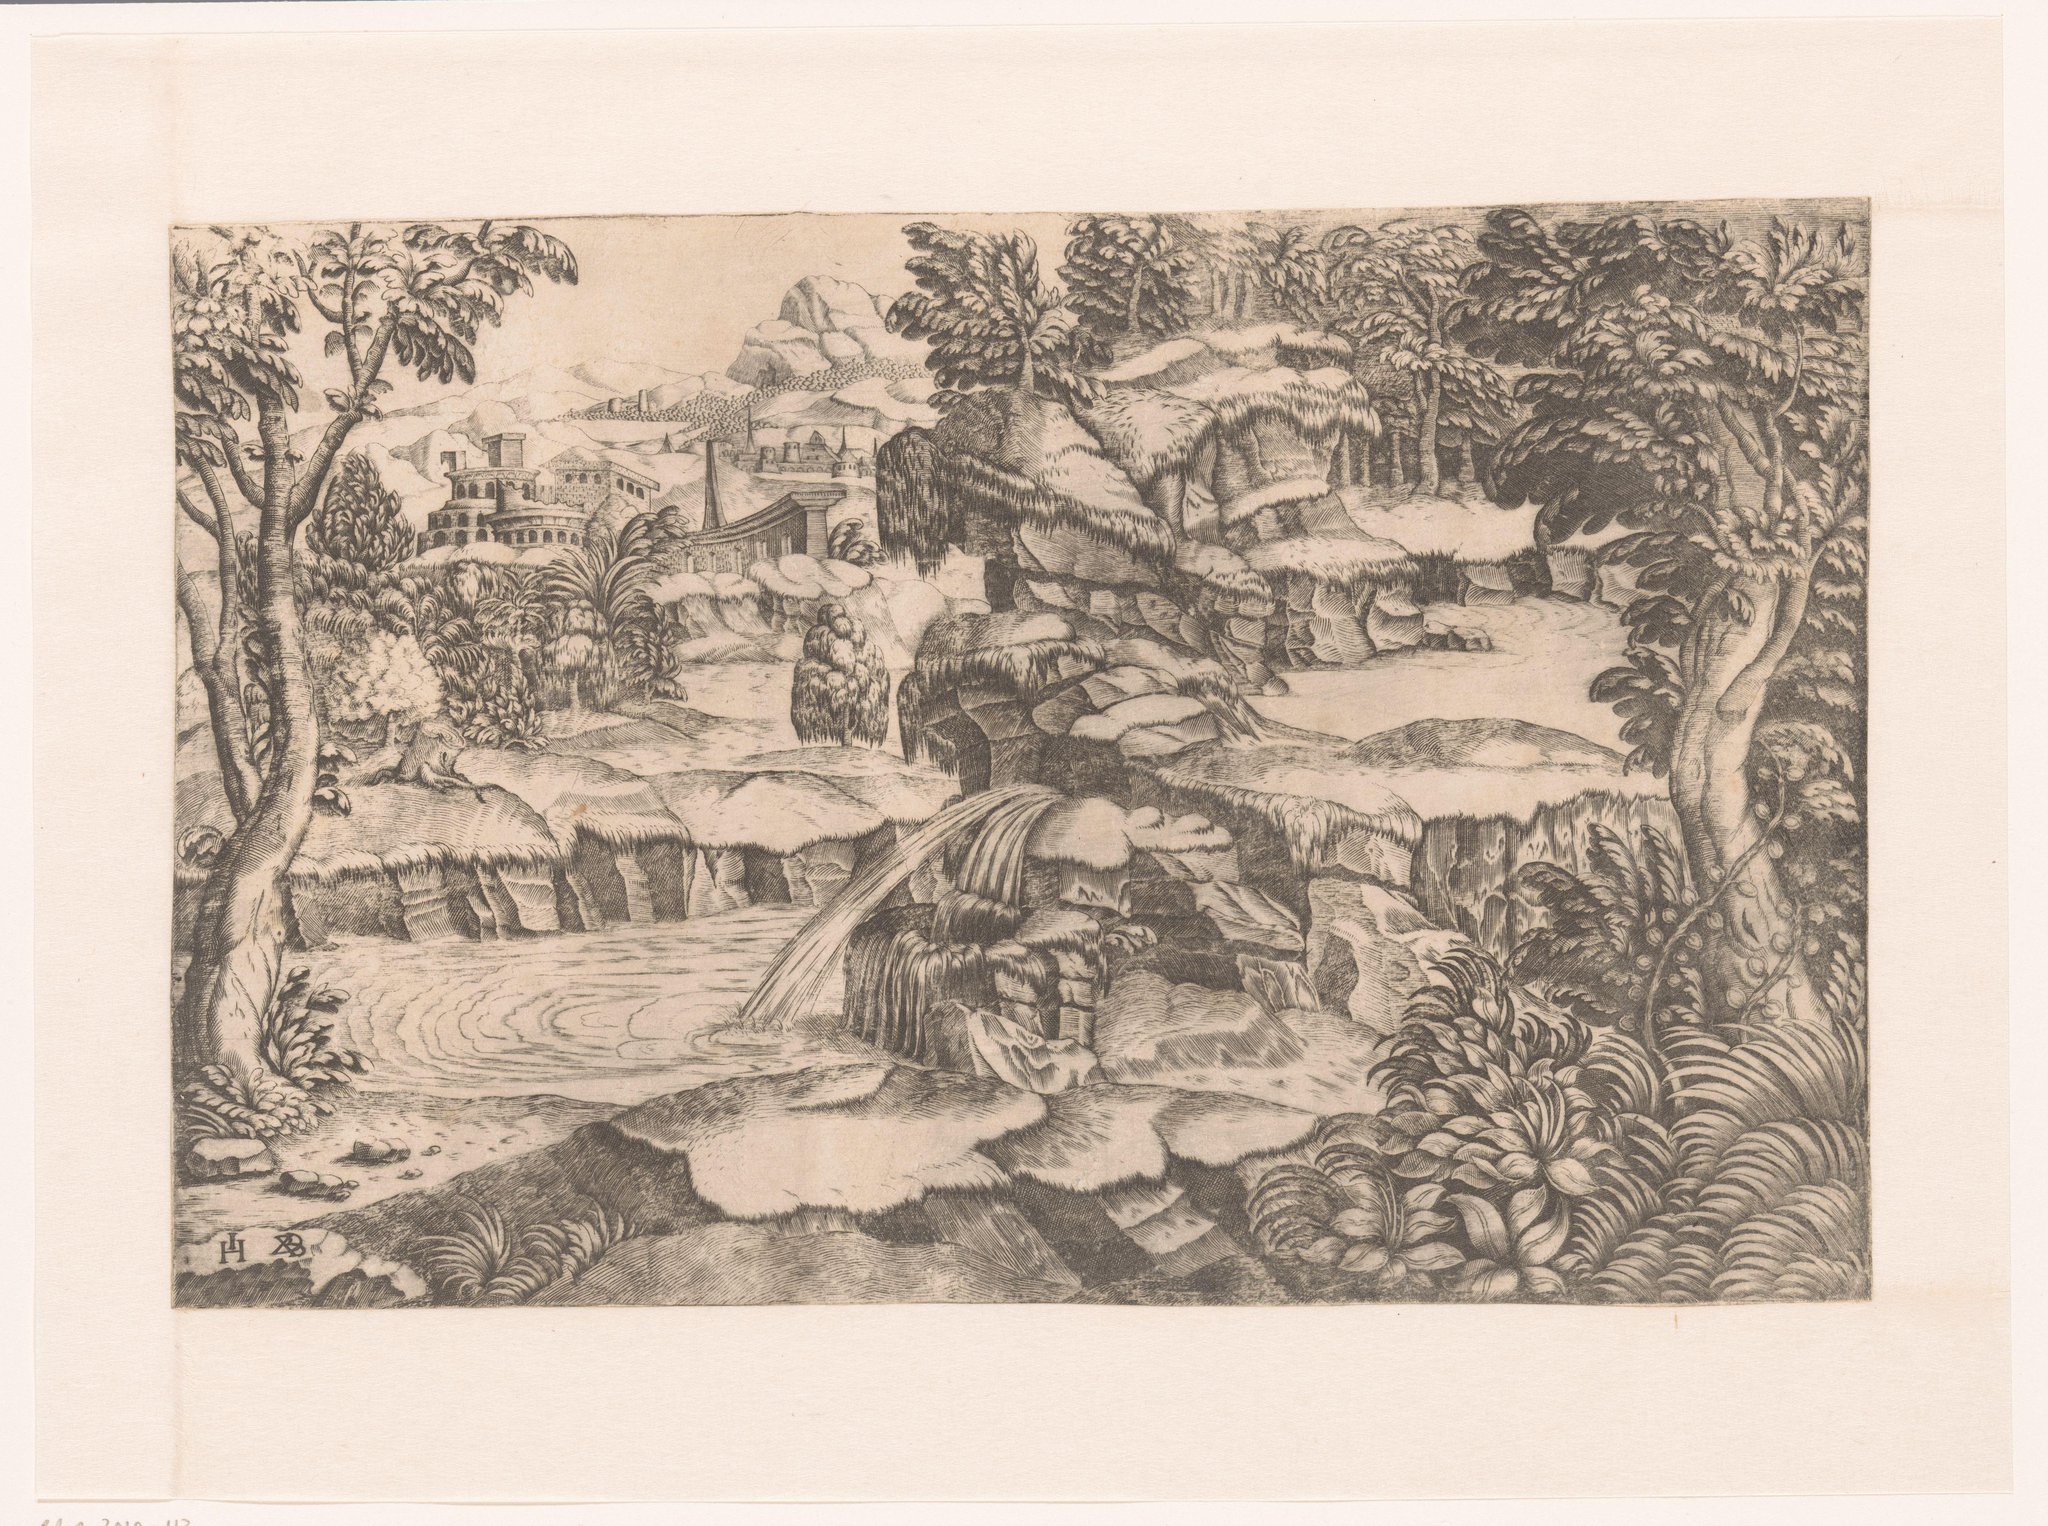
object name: print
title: Fantastisch landschap met beek, waterval en antieke ruïnen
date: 1550-1570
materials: paper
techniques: engraving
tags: waterfall - hh - ideal landscapes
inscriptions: collector's mark: Lugt 2760, collector's mark: Lugt 2228